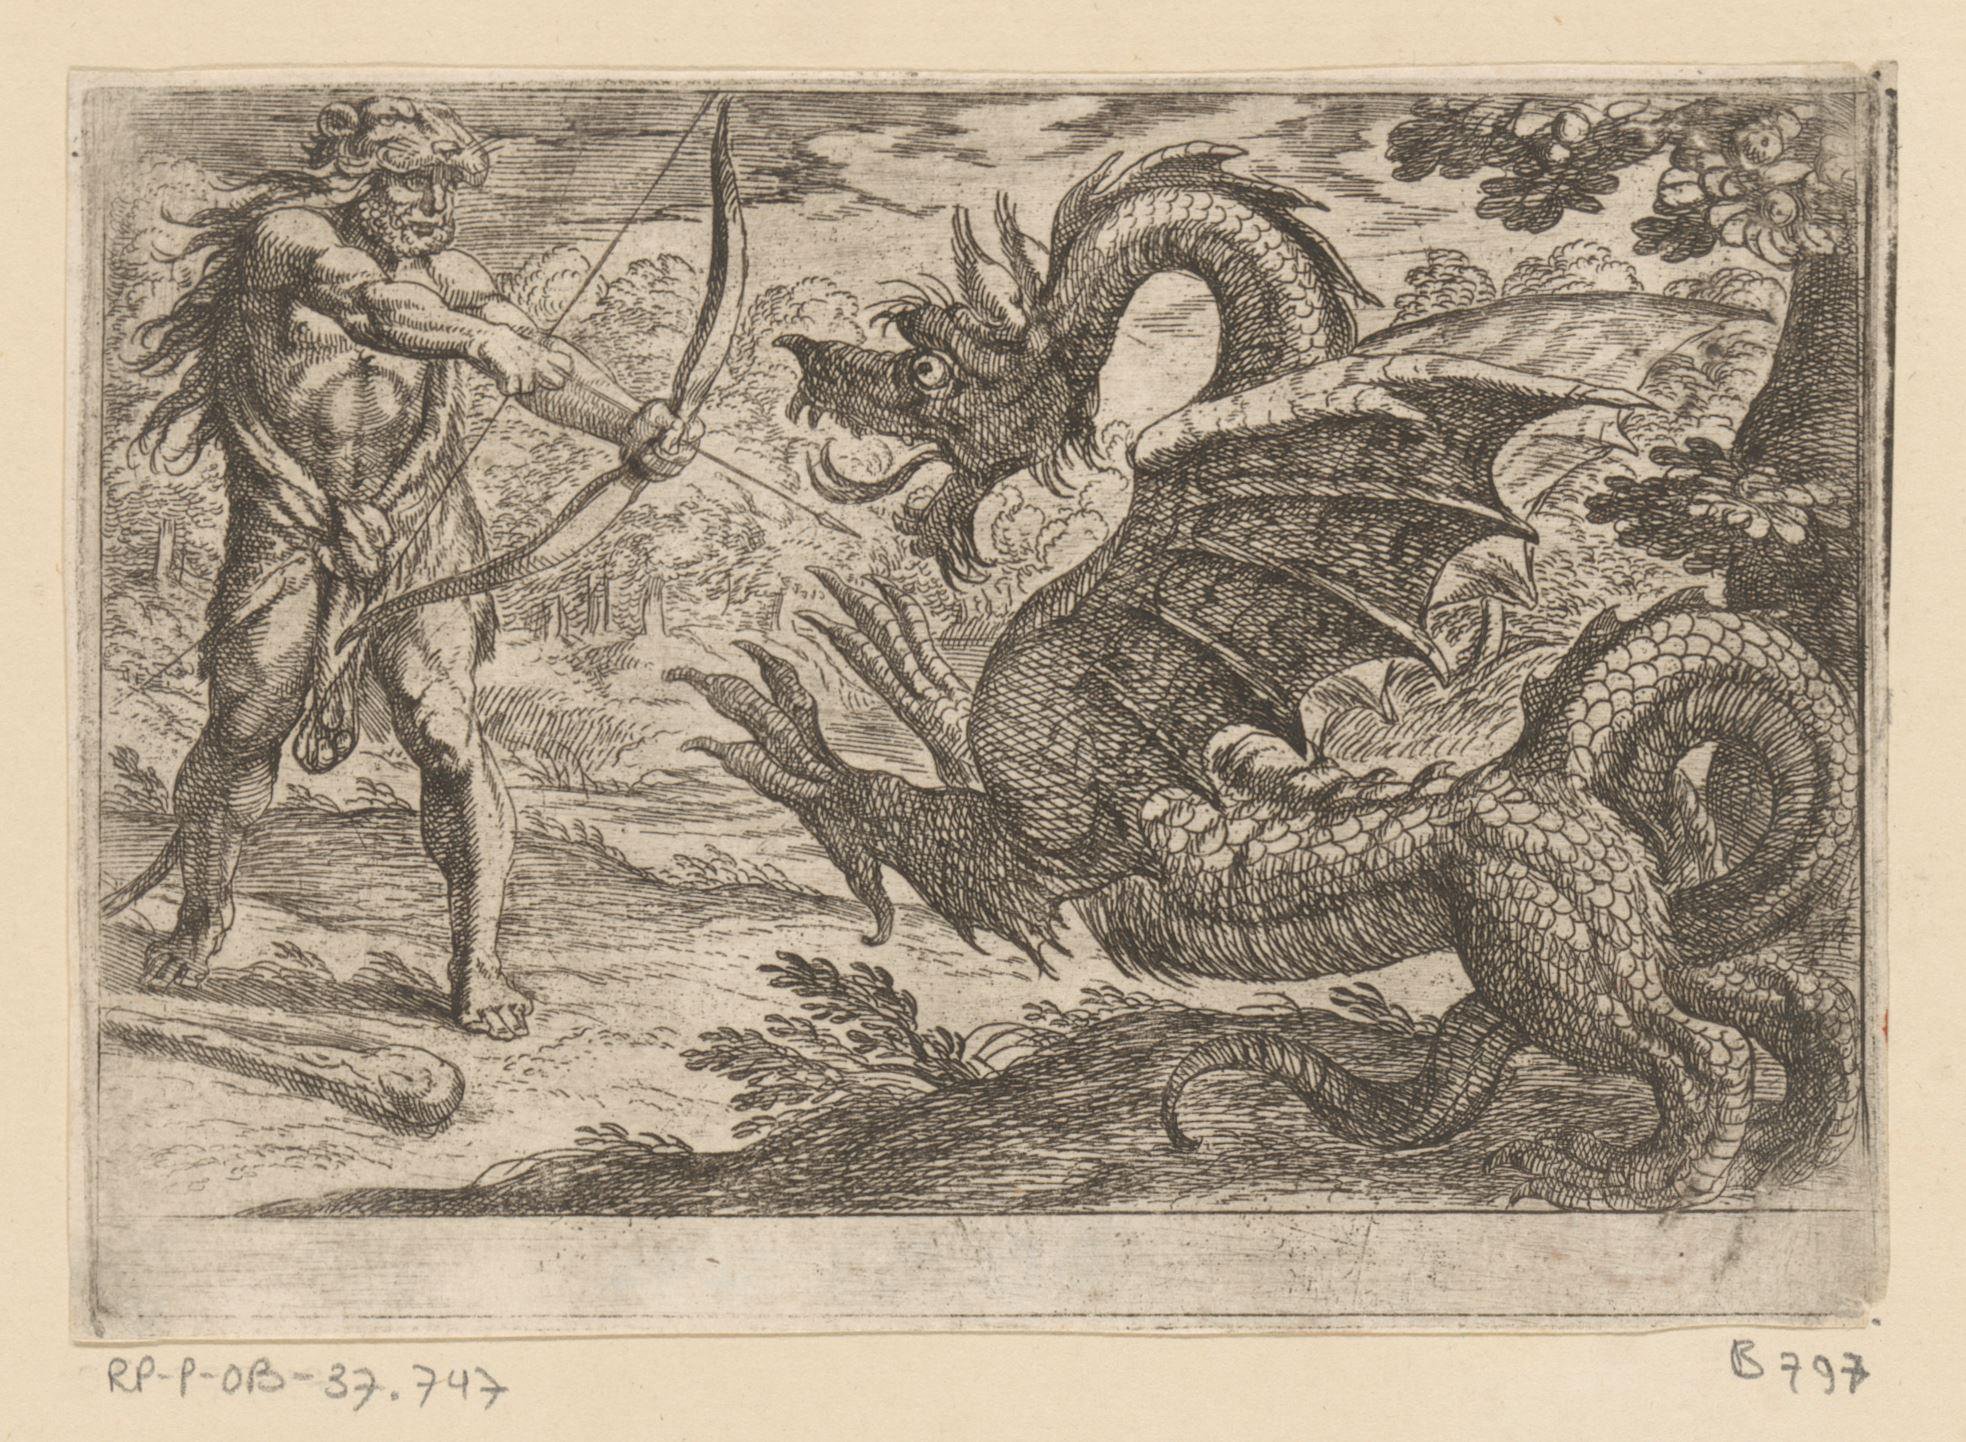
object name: print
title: Hercules en de draak Ladon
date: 1608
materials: paper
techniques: etching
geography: rome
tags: hercules kills ladon, the dragon which kept the tree of the hesperides, most important deeds of hercules: the twelve labours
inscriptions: collector's mark: Lugt 240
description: Deze prent maakt deel uit van een reeks van 12 prenten van de twaalf werken van Hercules (+ titelprent).